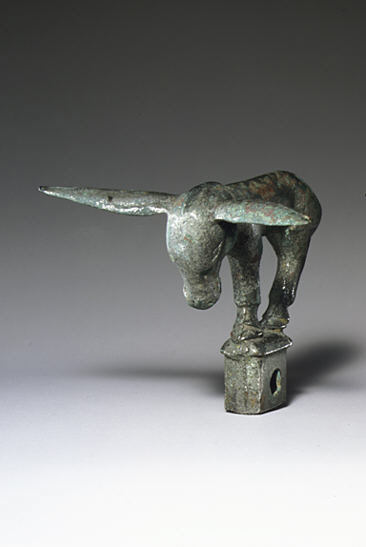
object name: finial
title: Finial in the Shape of Kulan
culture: chinese or mongolian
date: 400-301 BCE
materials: bronze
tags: animals